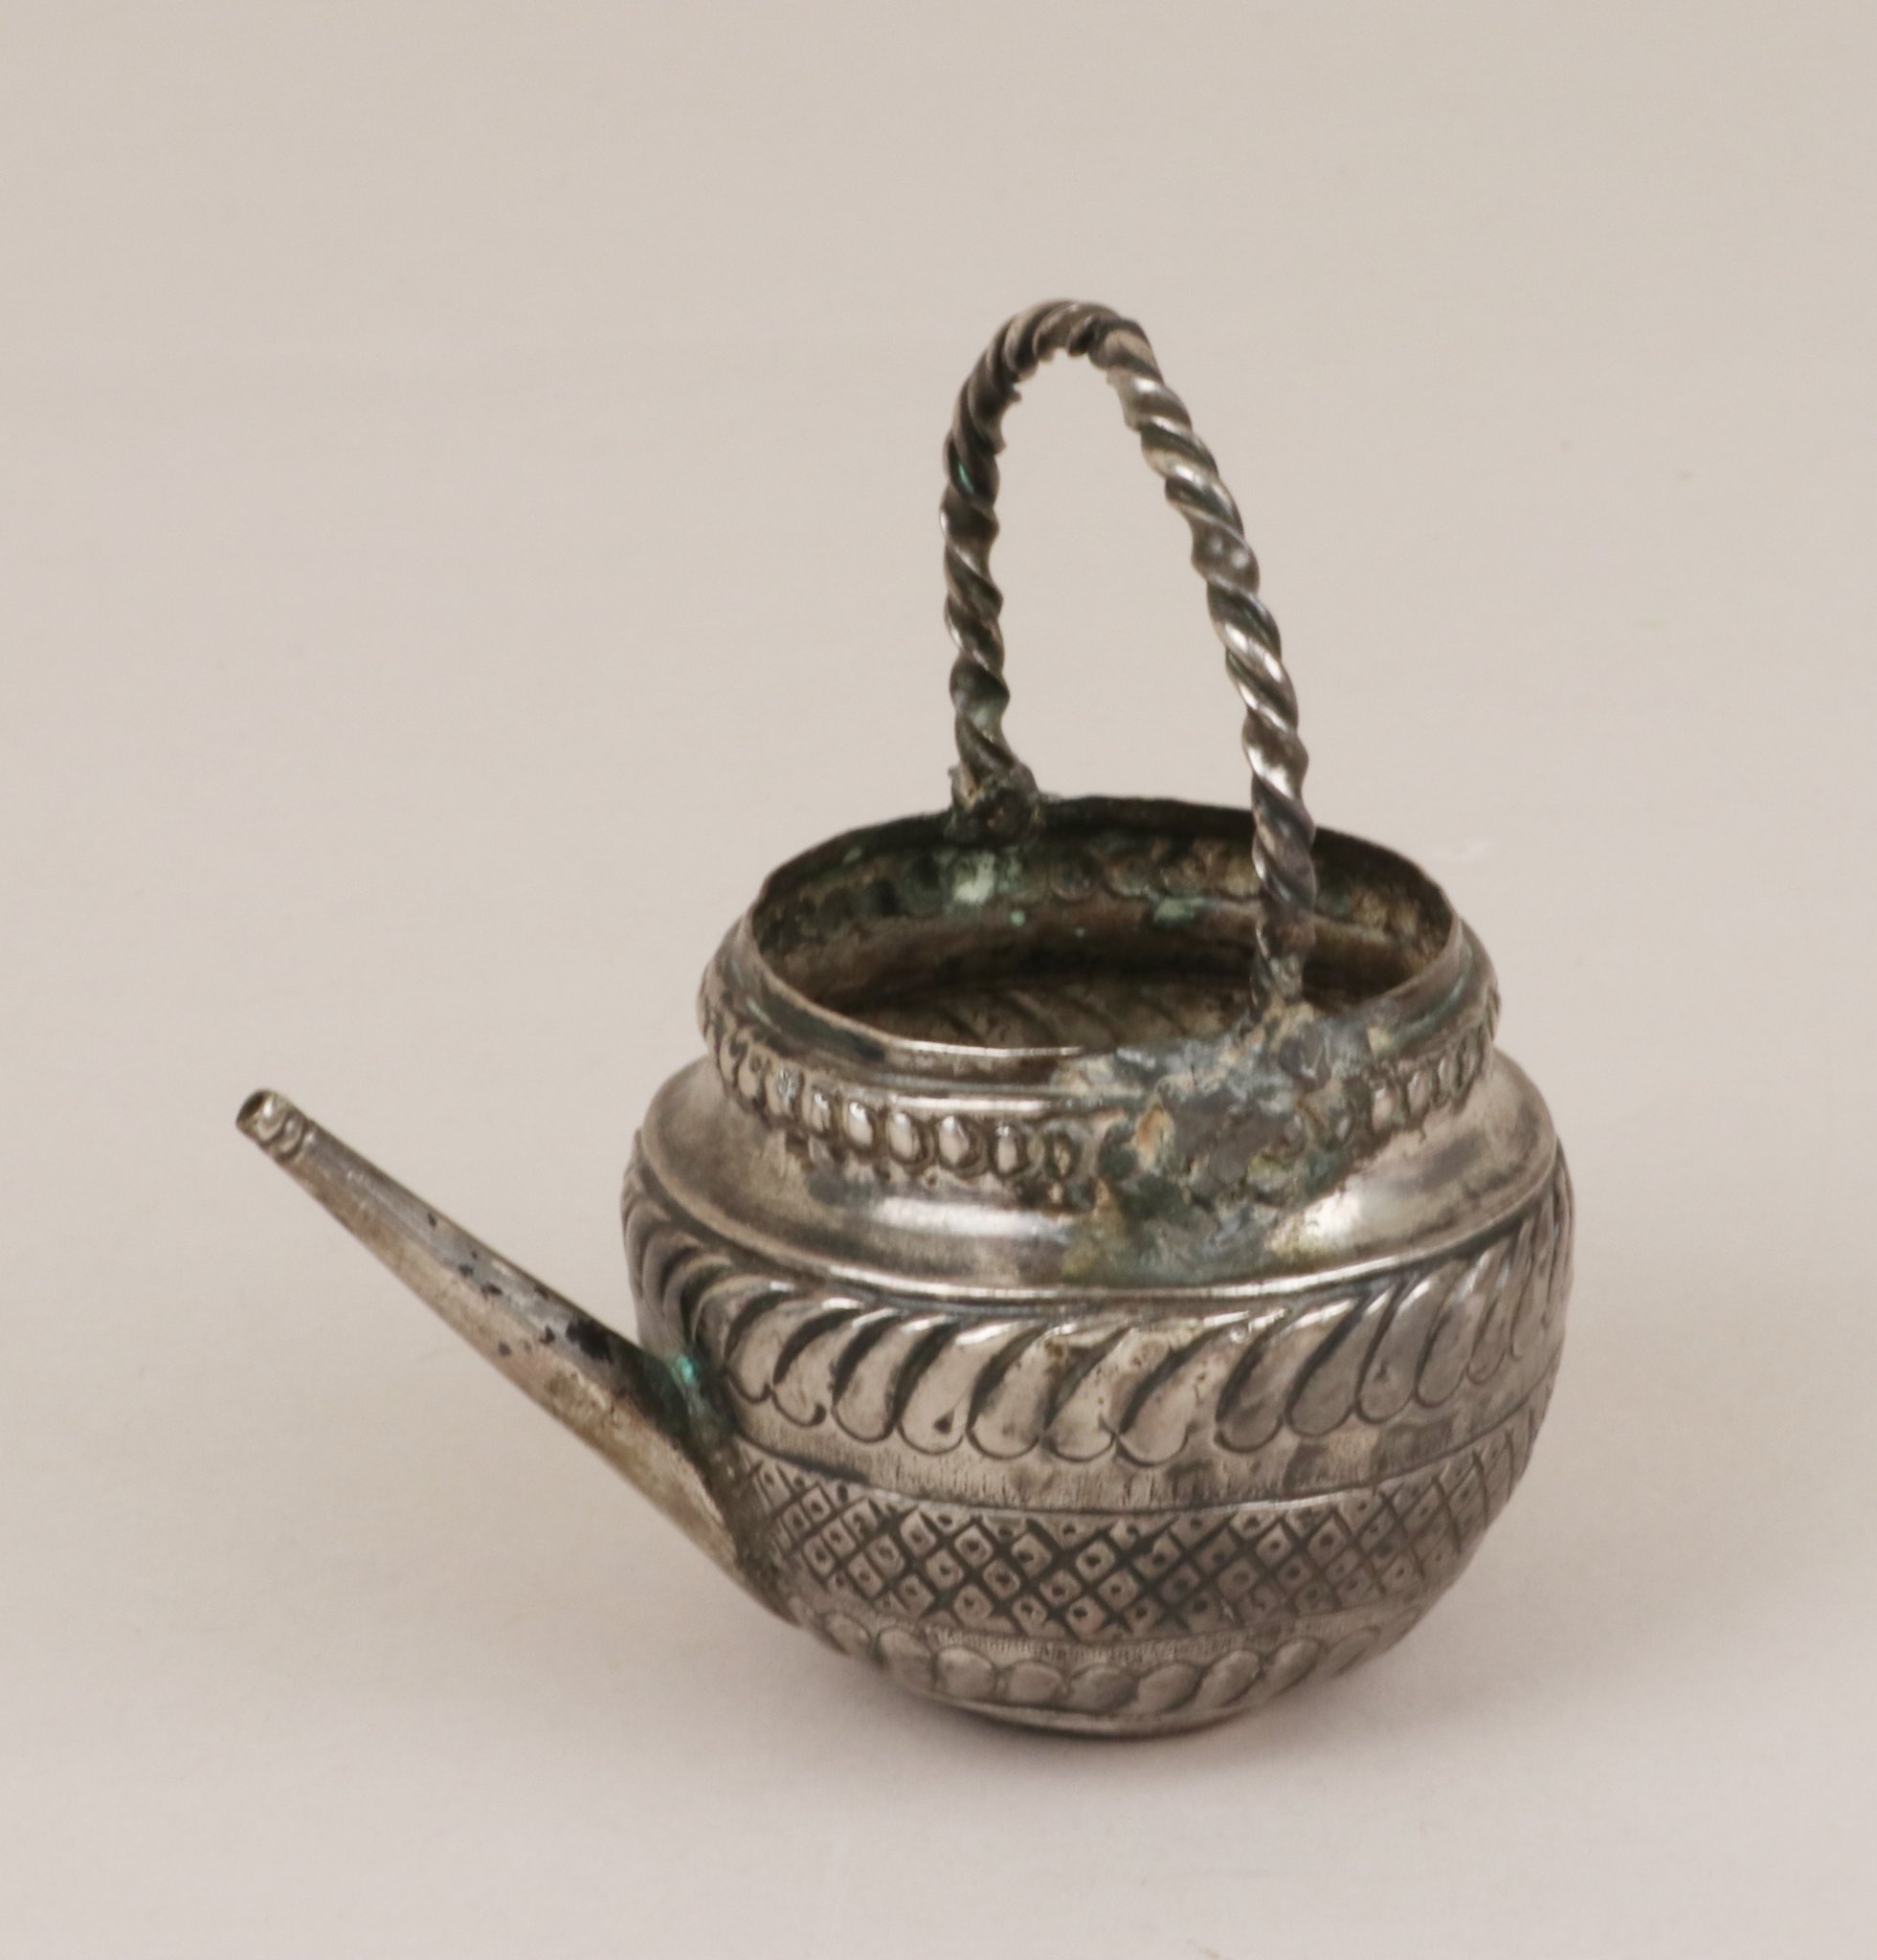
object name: crèche accessory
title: Silver vessel with handle and spout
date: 1701-1800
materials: silver